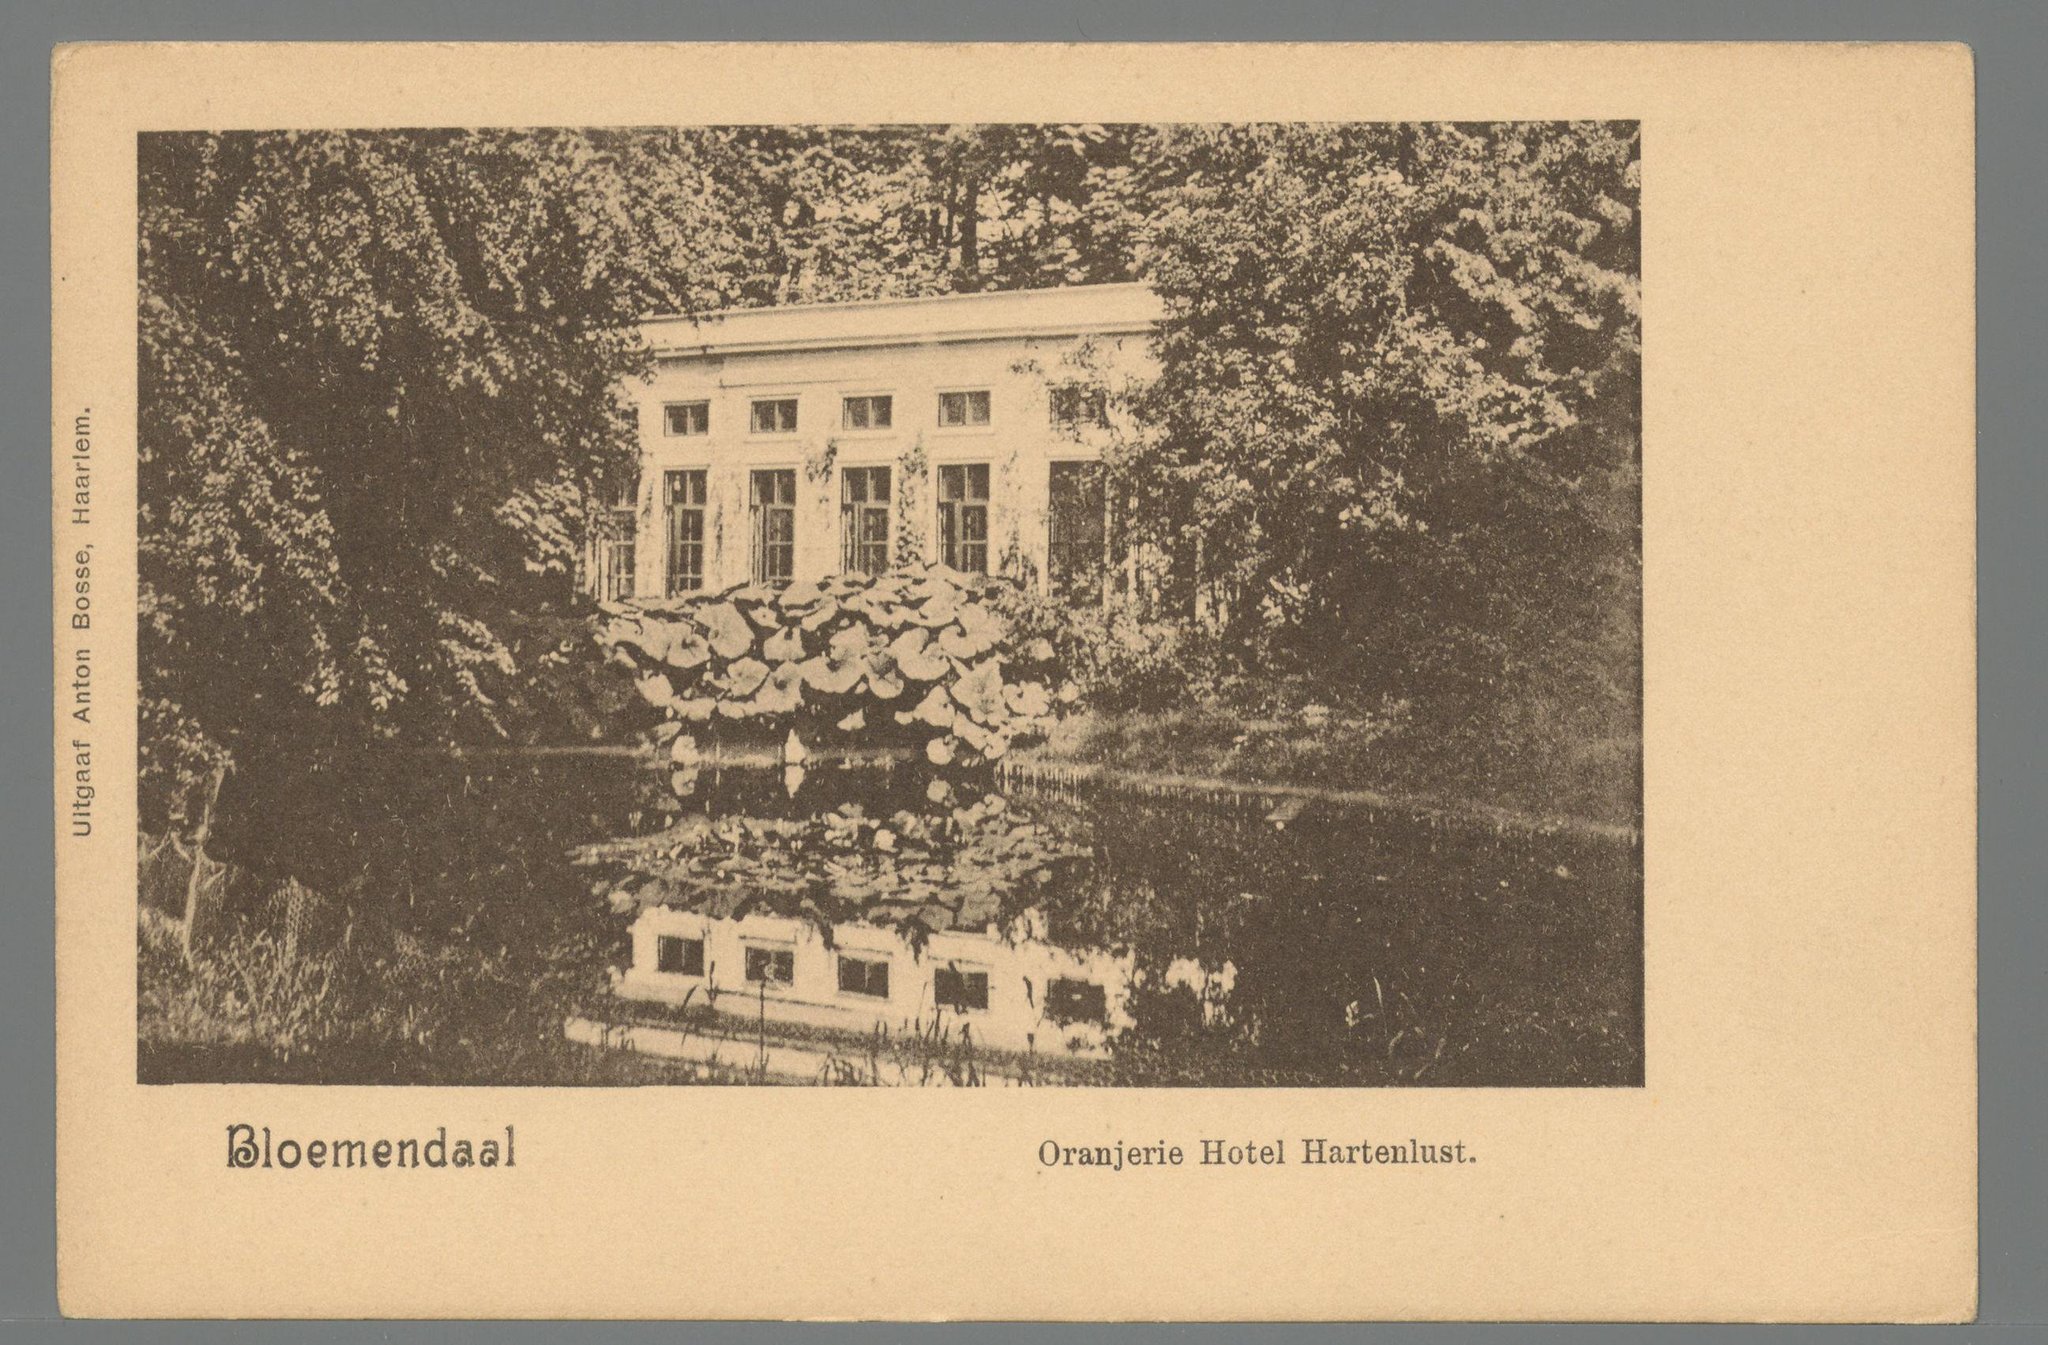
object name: ansichtkaart, prentbriefkaart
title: Bloemendaal. Oranjerie Hotel Hartenlust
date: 1892-1905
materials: cardboard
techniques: photograph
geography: haarlem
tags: pond, hotel, hostelry, inn